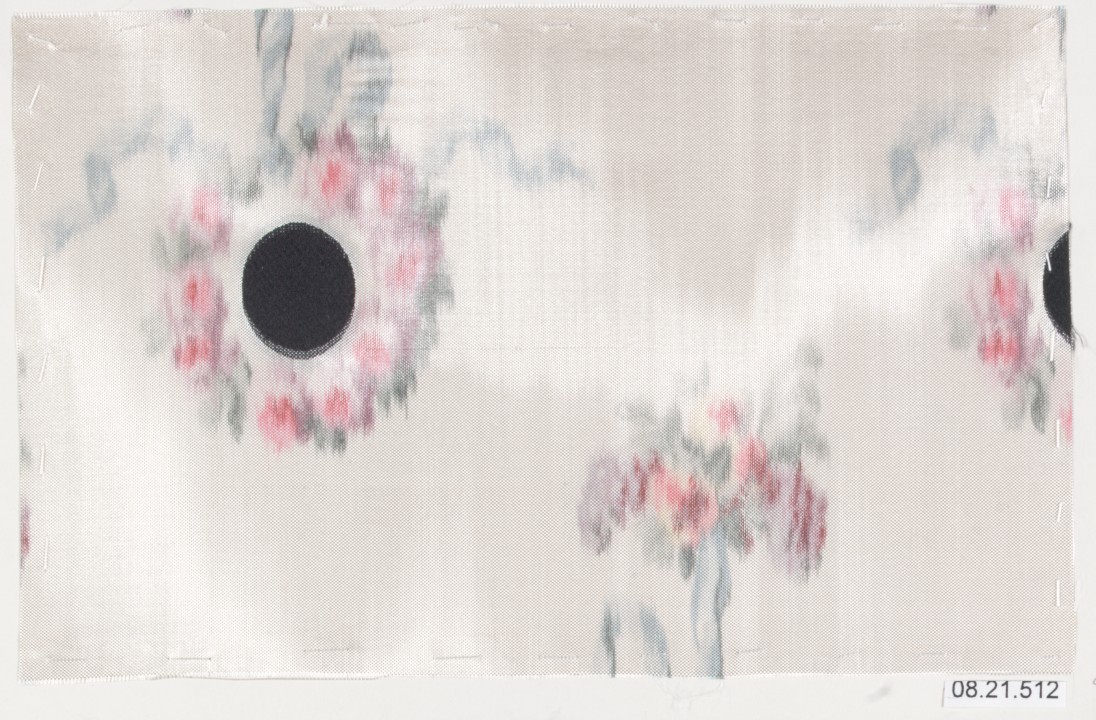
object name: textile sample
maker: Anonymous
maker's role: designer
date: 1900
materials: silk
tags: flowers